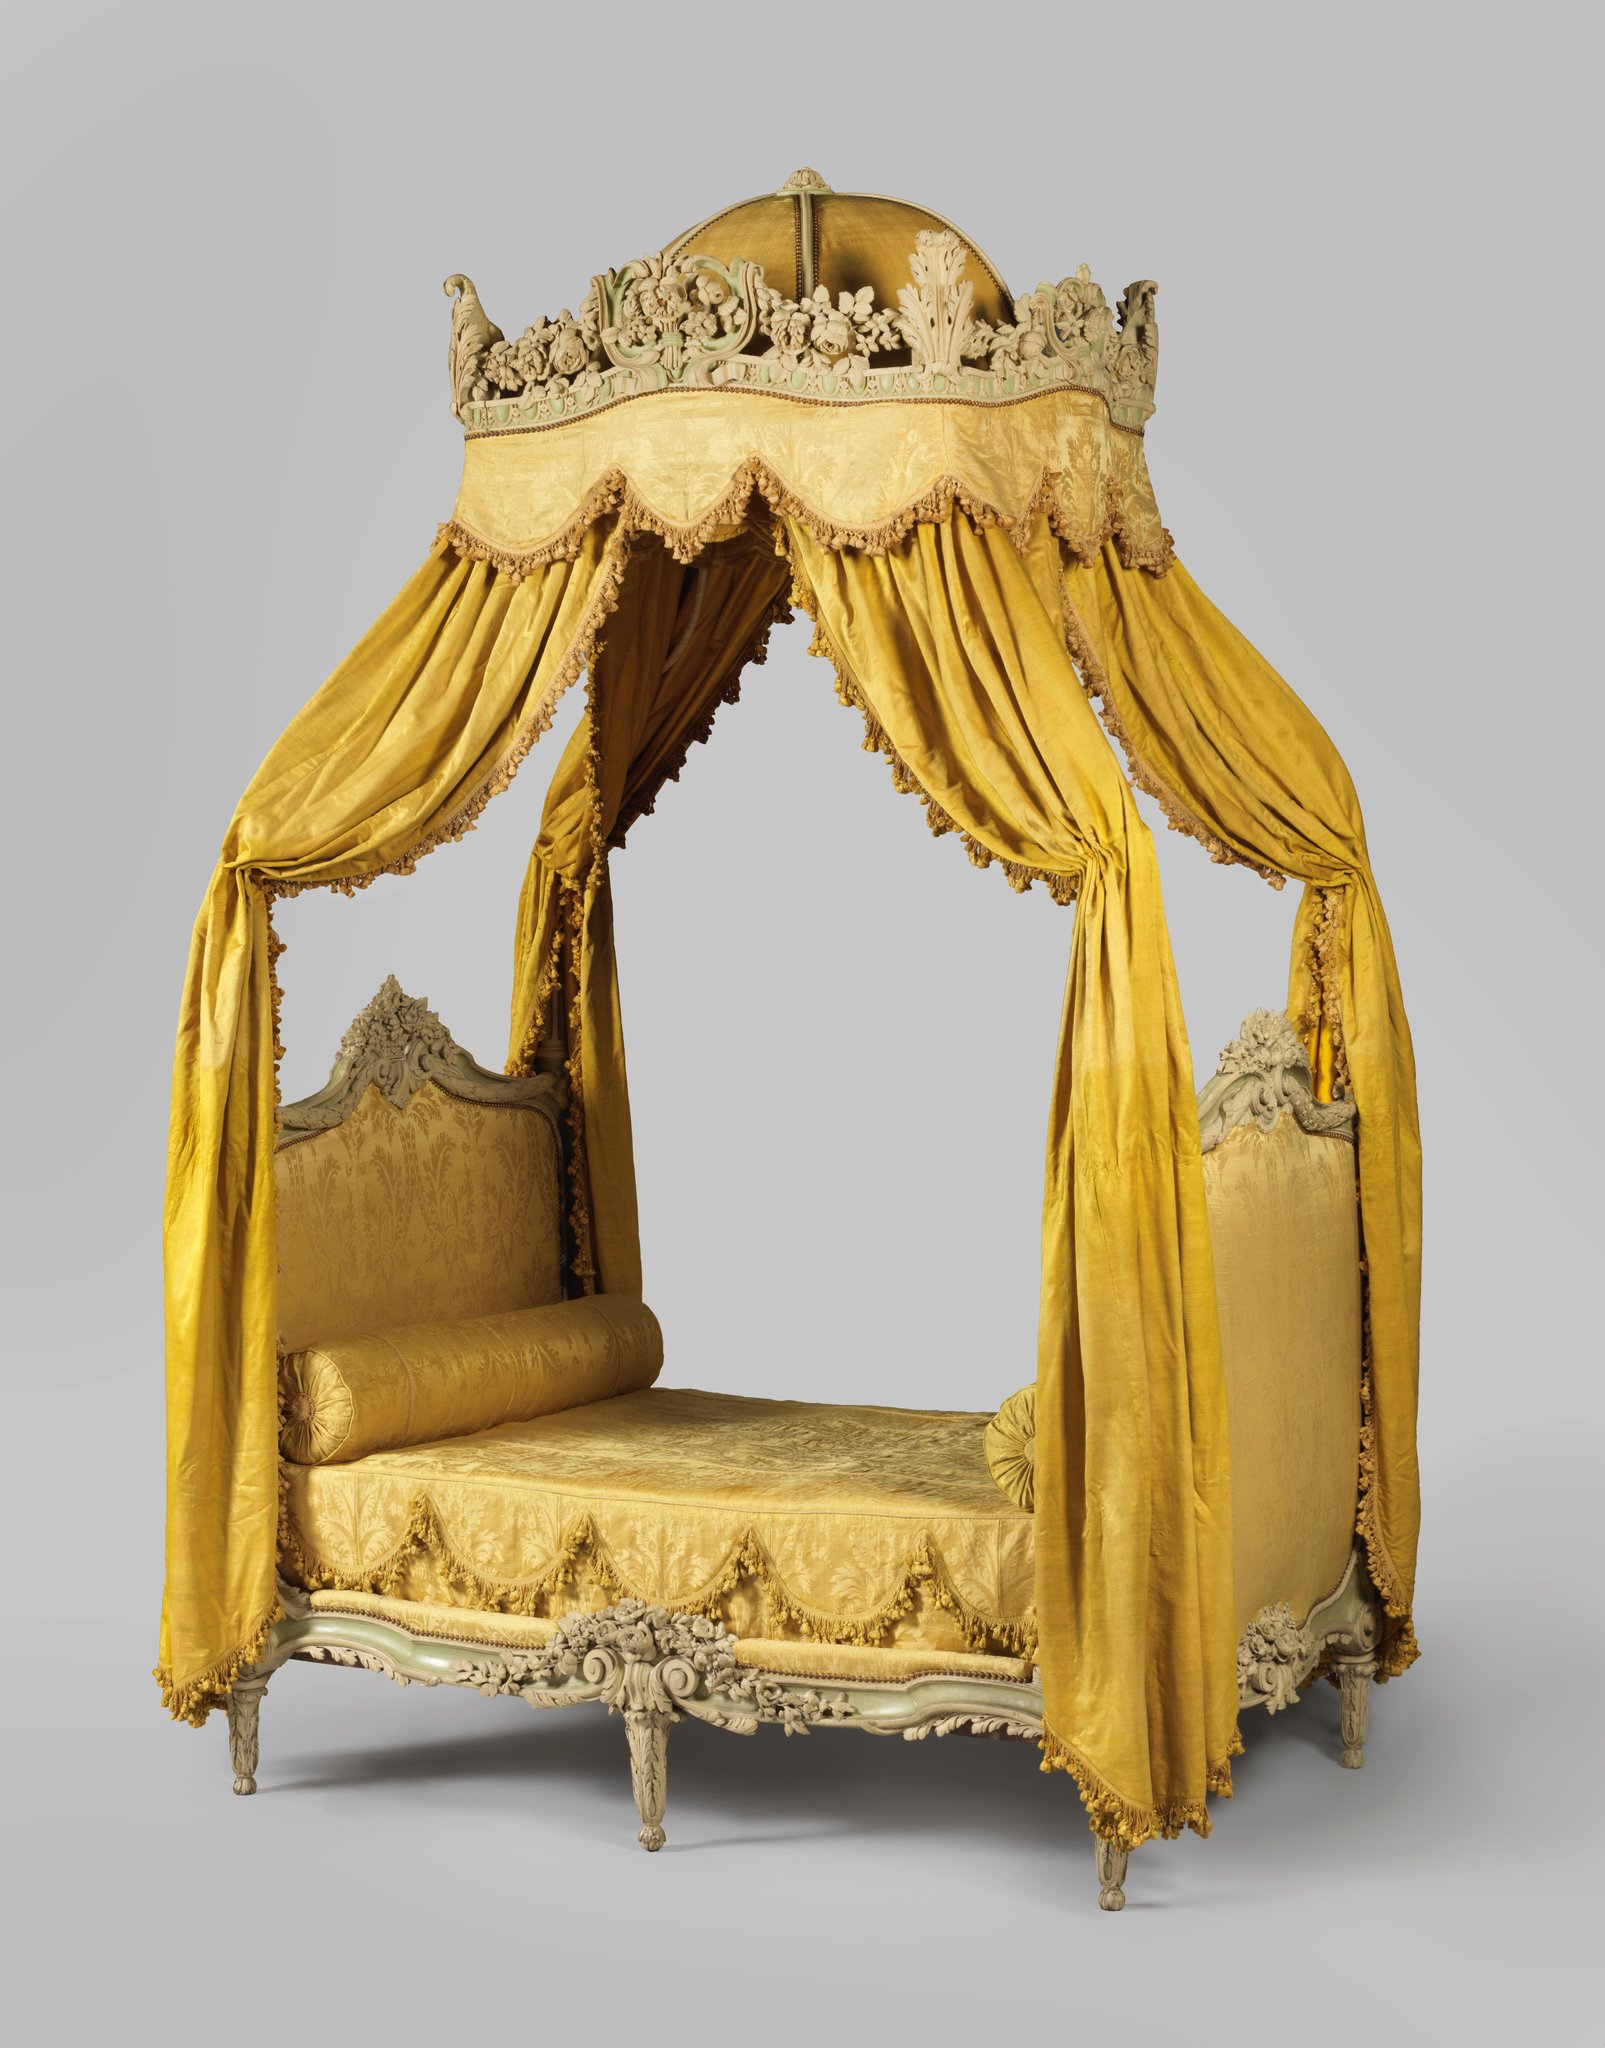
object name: ledikant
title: De hemel van het Lit à la Polonaise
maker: Anonymous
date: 1775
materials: wood, copper, iron, paint, textile, silk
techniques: cutting, damask, painted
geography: france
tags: bed